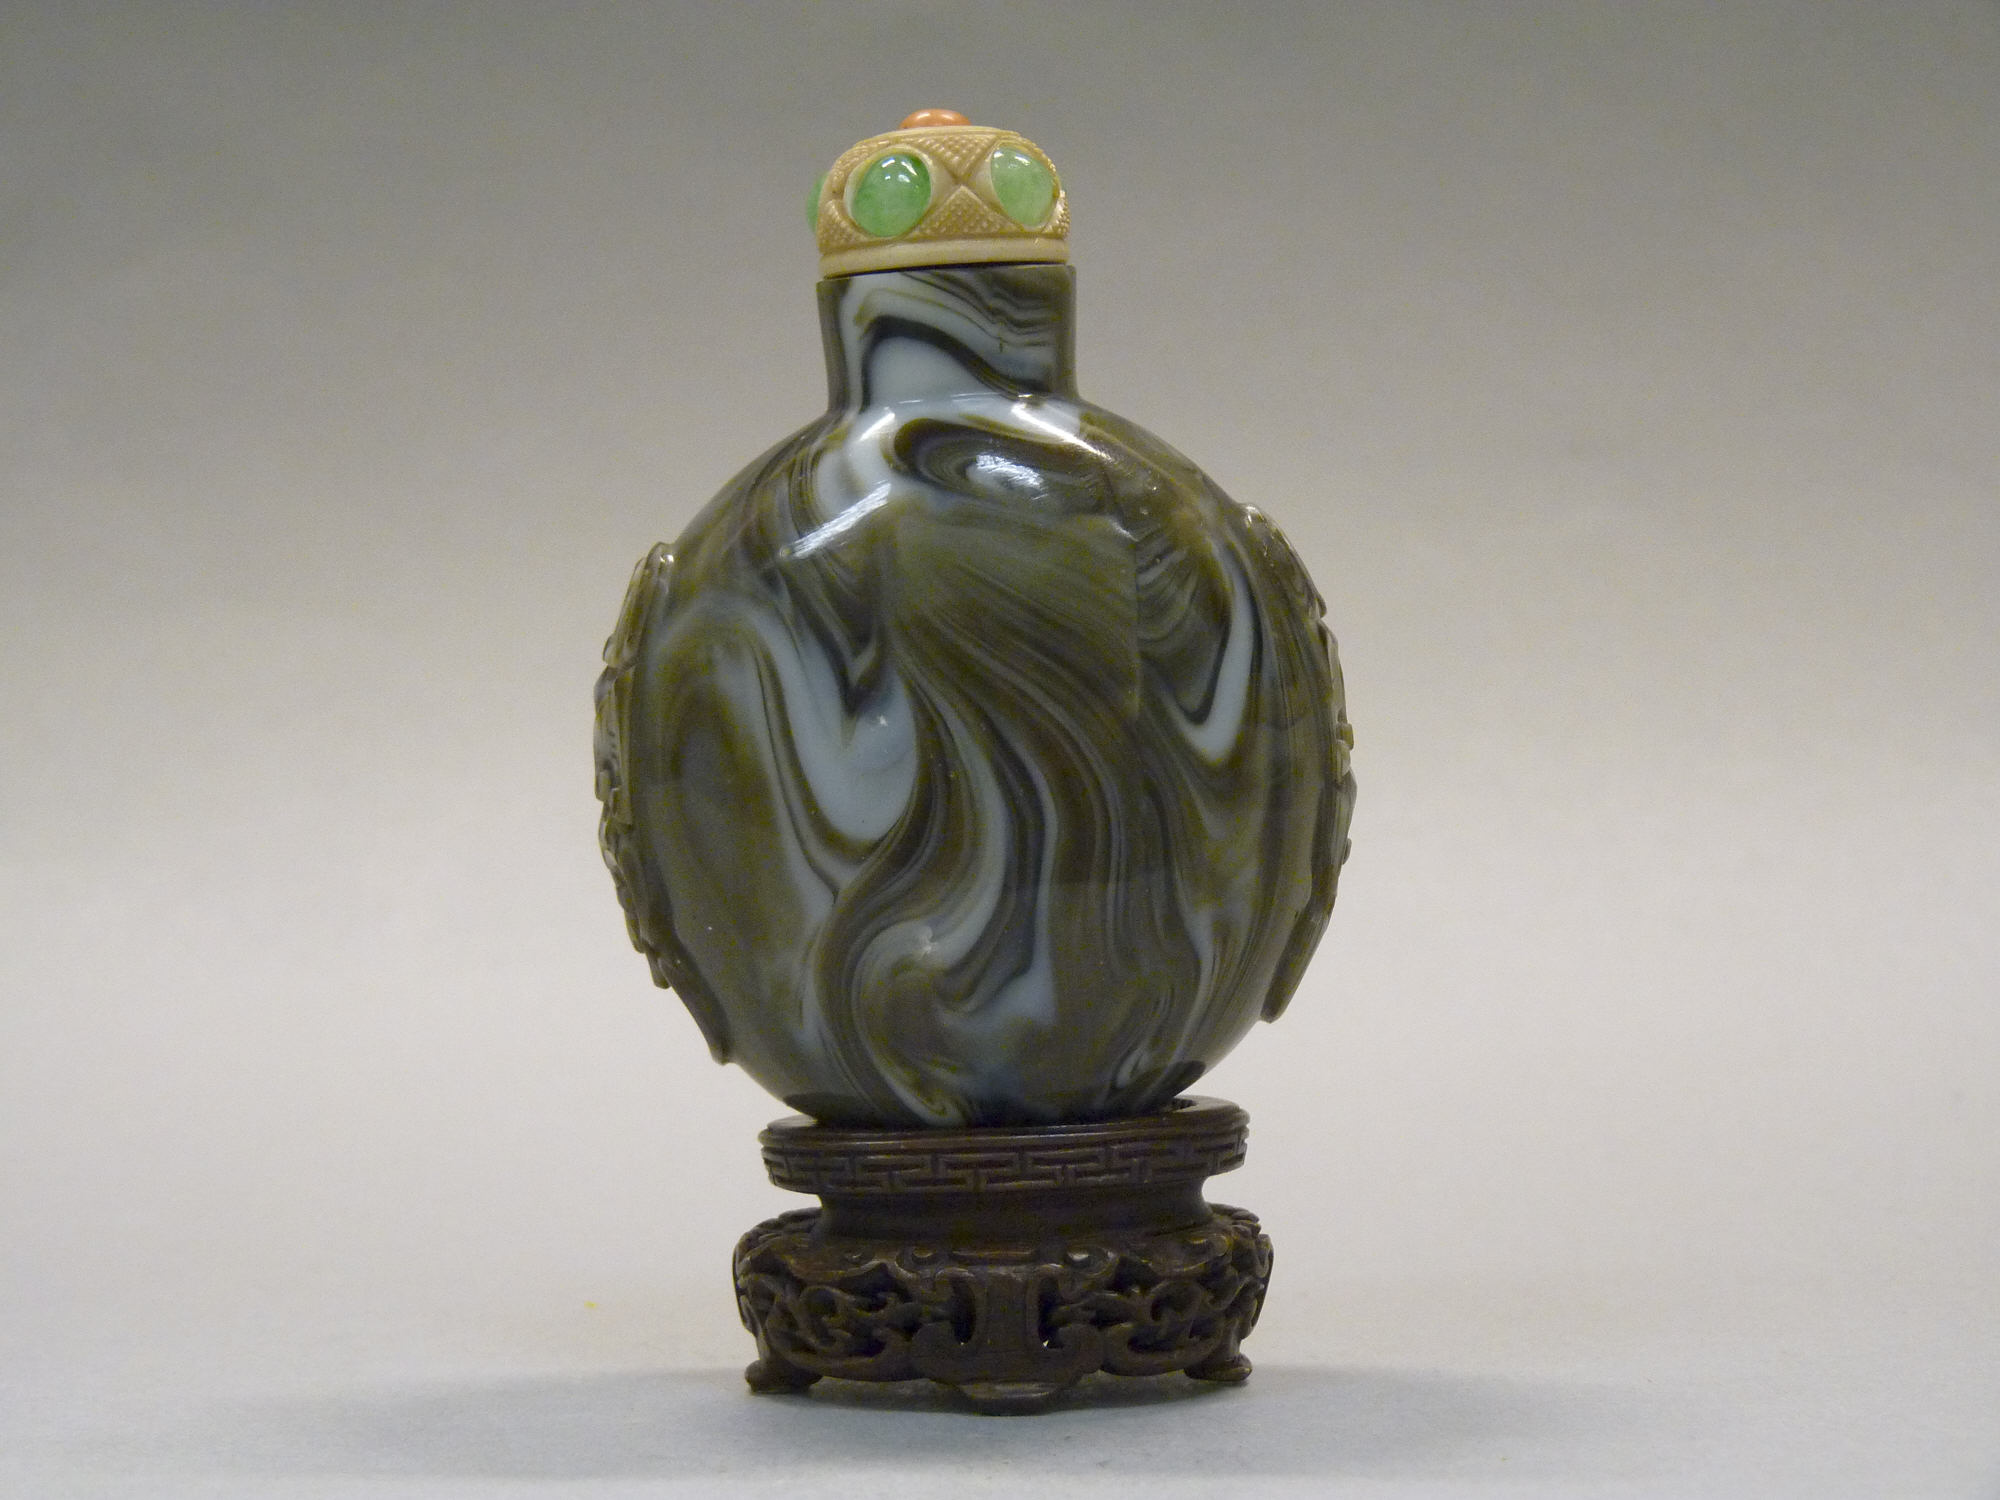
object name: snuff bottle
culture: chinese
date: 1736-1795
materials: glass, ivory, stone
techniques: inlay